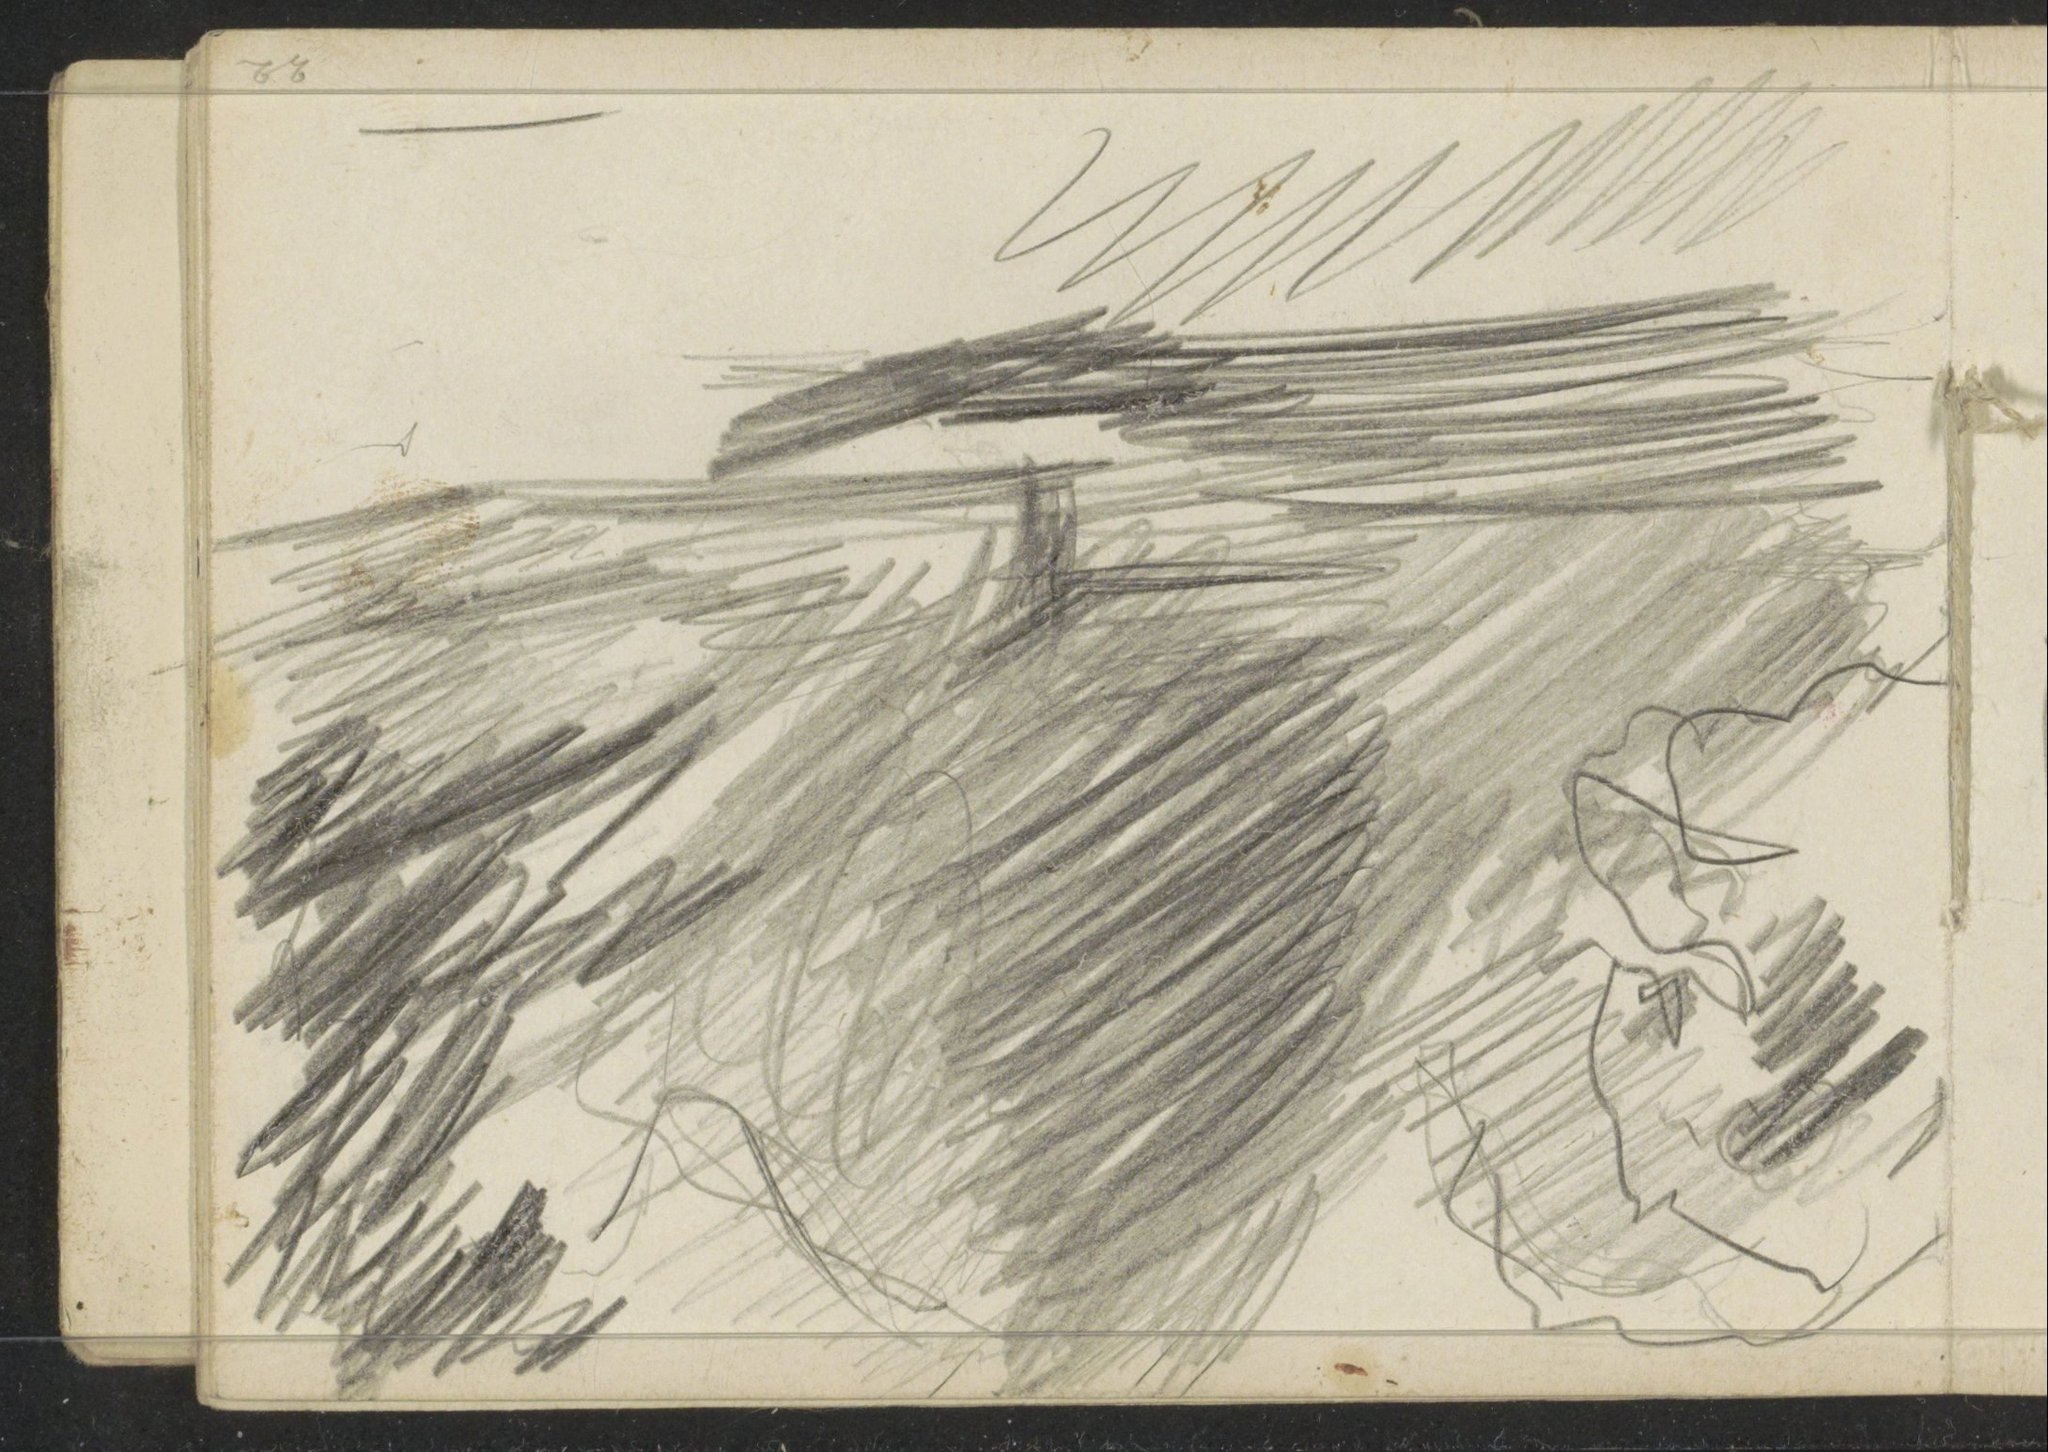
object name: sketchbook leaf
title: Boom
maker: isaac israels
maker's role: draughtsman, painter, print maker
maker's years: 1865-1934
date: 1923-1934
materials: paper, pencil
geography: the hague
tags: trees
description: Blad 7 verso uit schetsboek LVIII met 14 bladen.